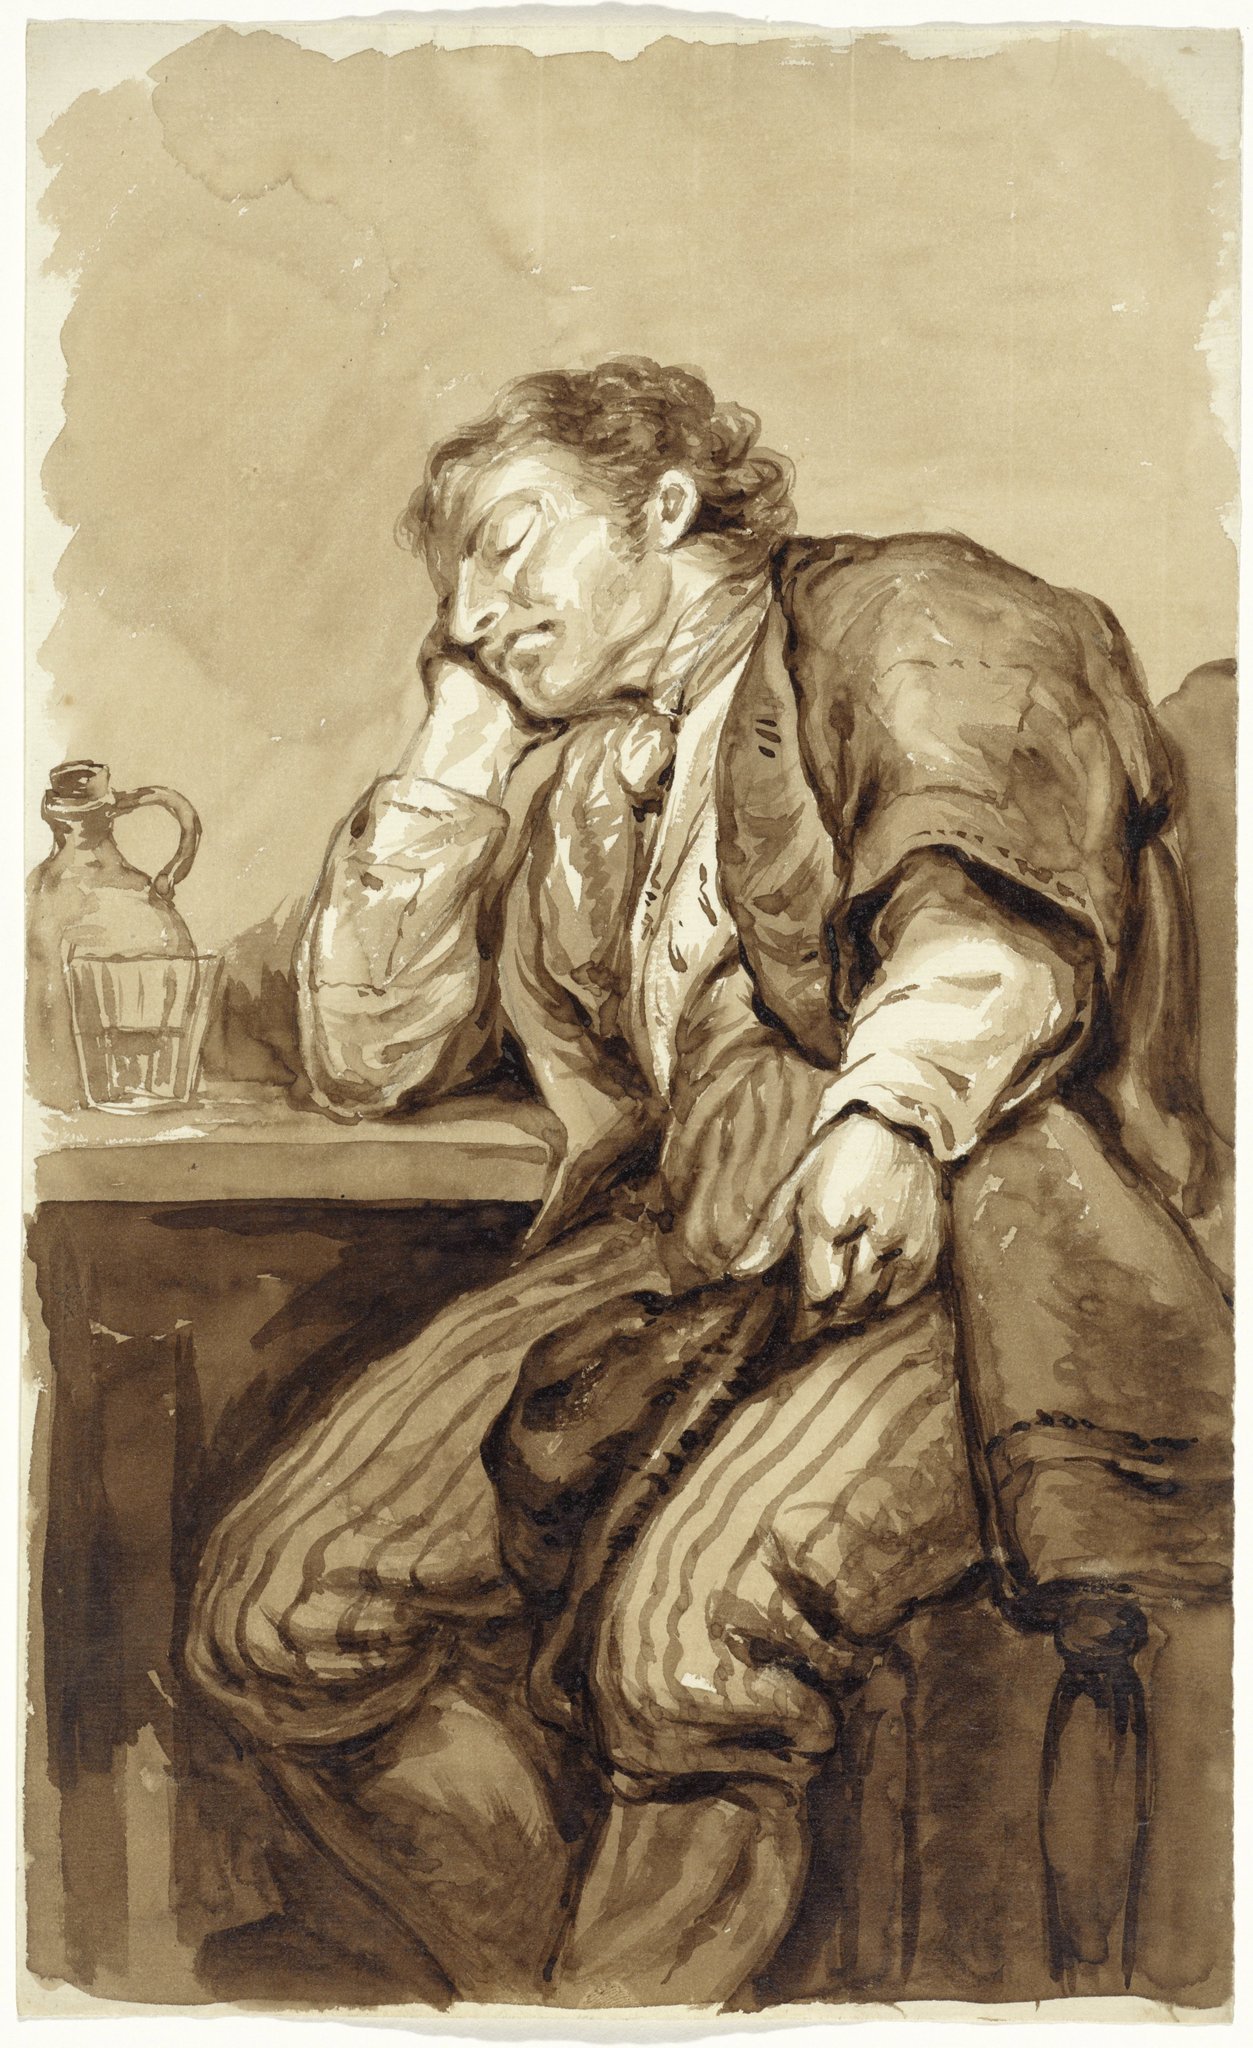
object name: drawing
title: Slapende man, gezeten aan een tafel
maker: pieter van loon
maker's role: draughtsman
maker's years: 1801-1873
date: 1811-1873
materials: paper, pencil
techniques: brush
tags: sleeping; unconsciousness